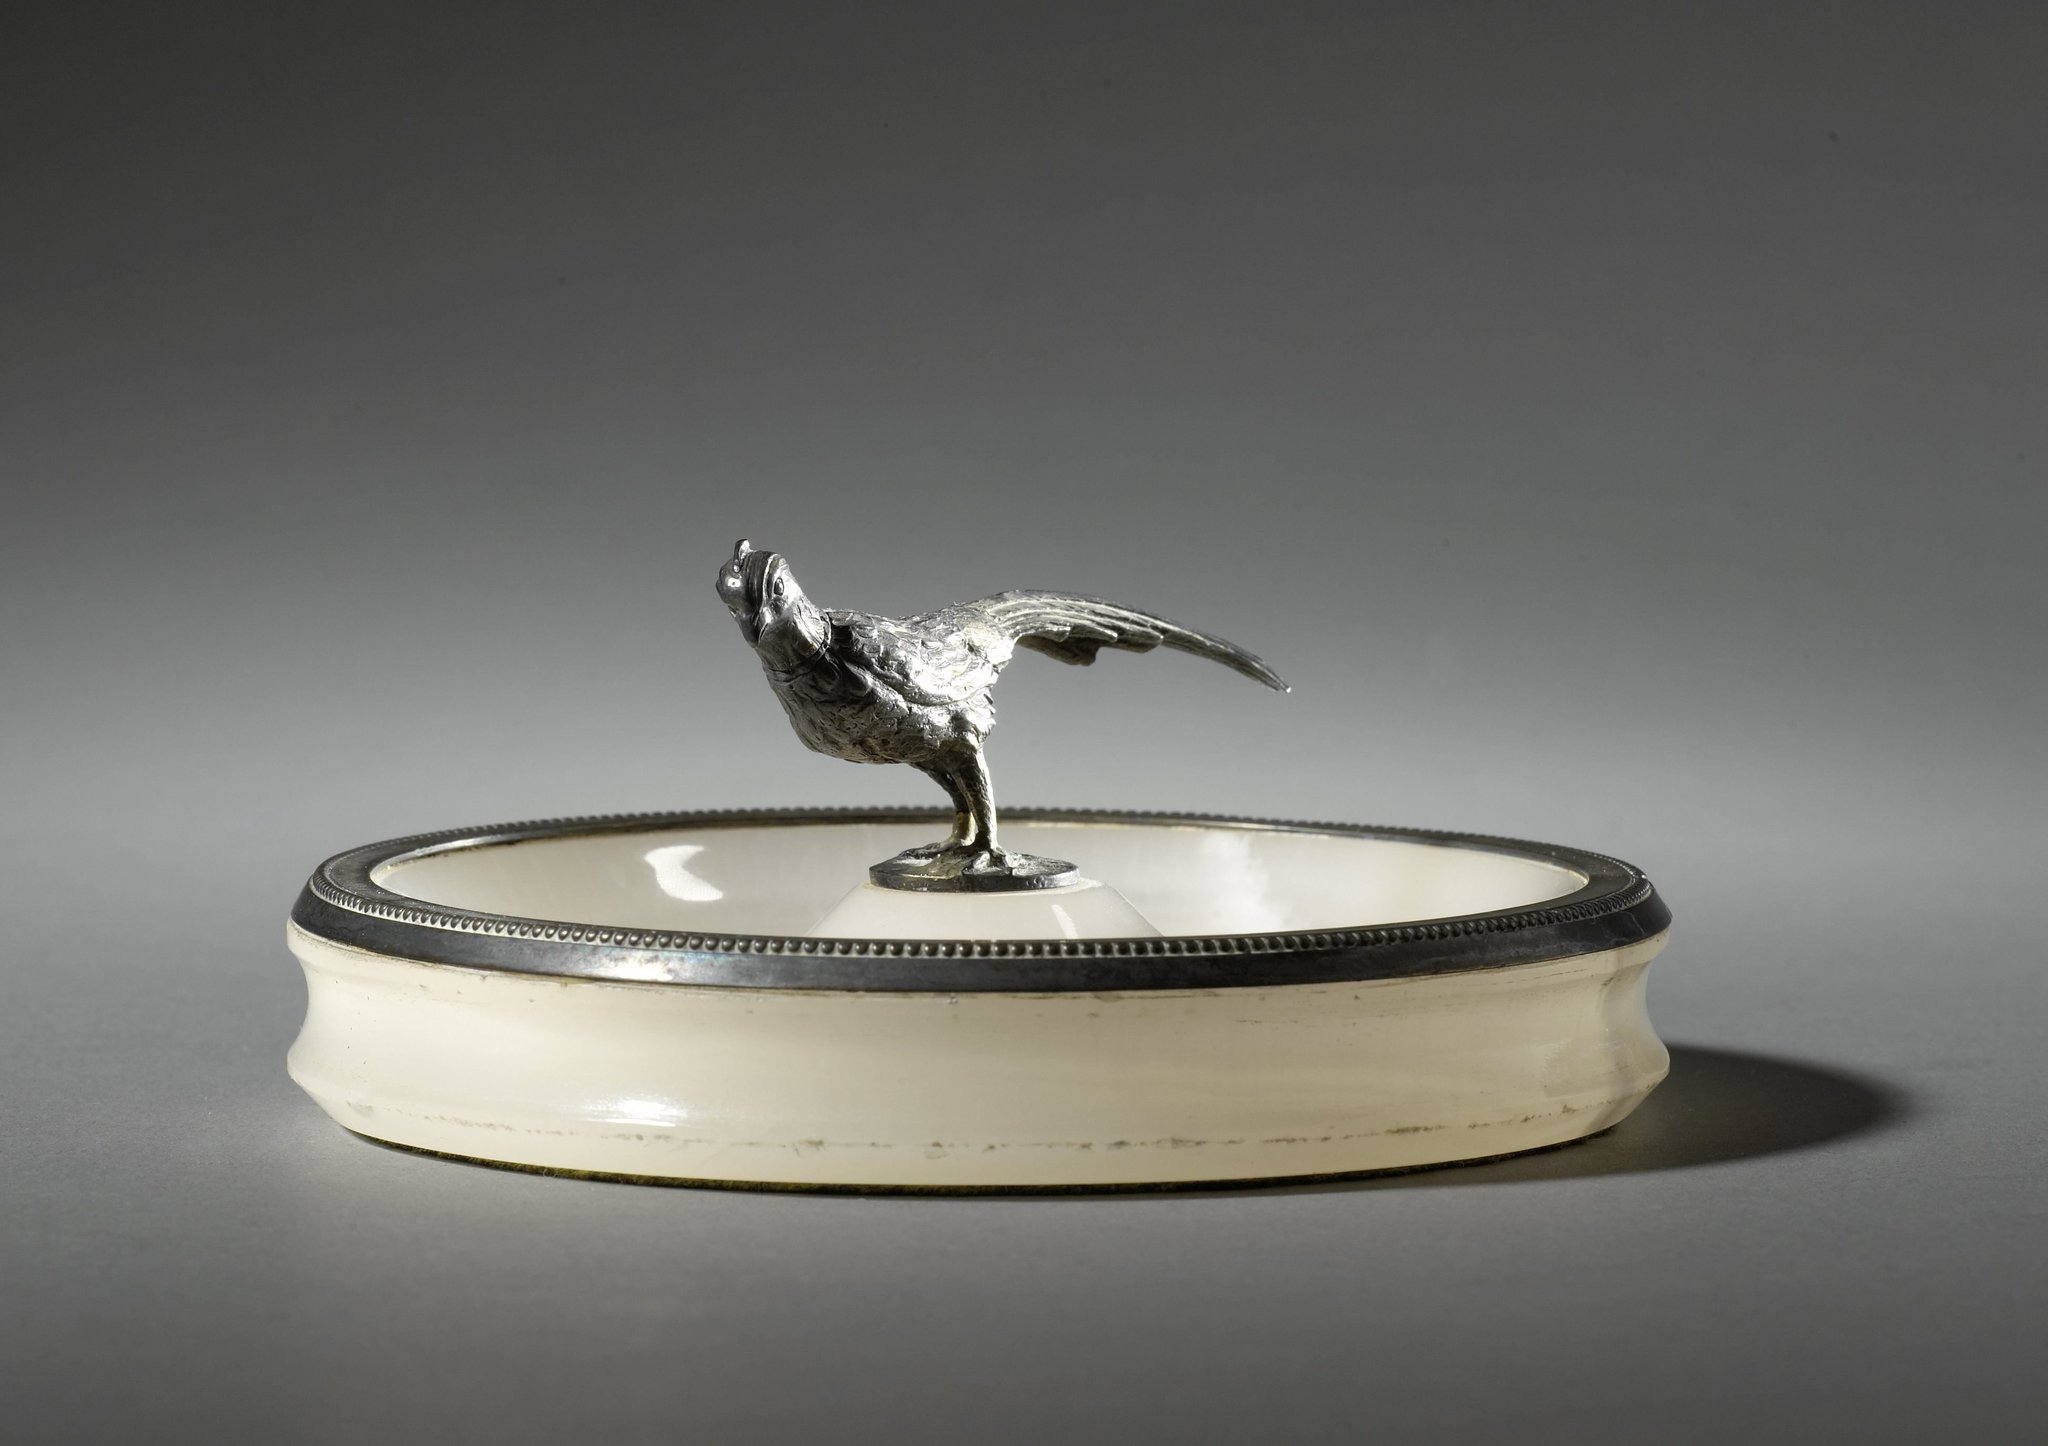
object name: ashtray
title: Asbak die Willem Drees als geschenk heeft ontvangen als getuige bij het huwelijk van prins Claus en prinses Beatrix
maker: Anonymous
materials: earthenware, felt, metal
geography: netherlands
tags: amsterdam, beatrix (koningin der nederlanden), the hague, willem drees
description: Willem Drees was getuige bij het huwelijk van prins Claus en prinses Beatrix, mede omdat hij in een vroeg stadium zich had uitgesproken voor acceptatie van Claus, waar in de sociaaldemocratische kring nog weerstand was.